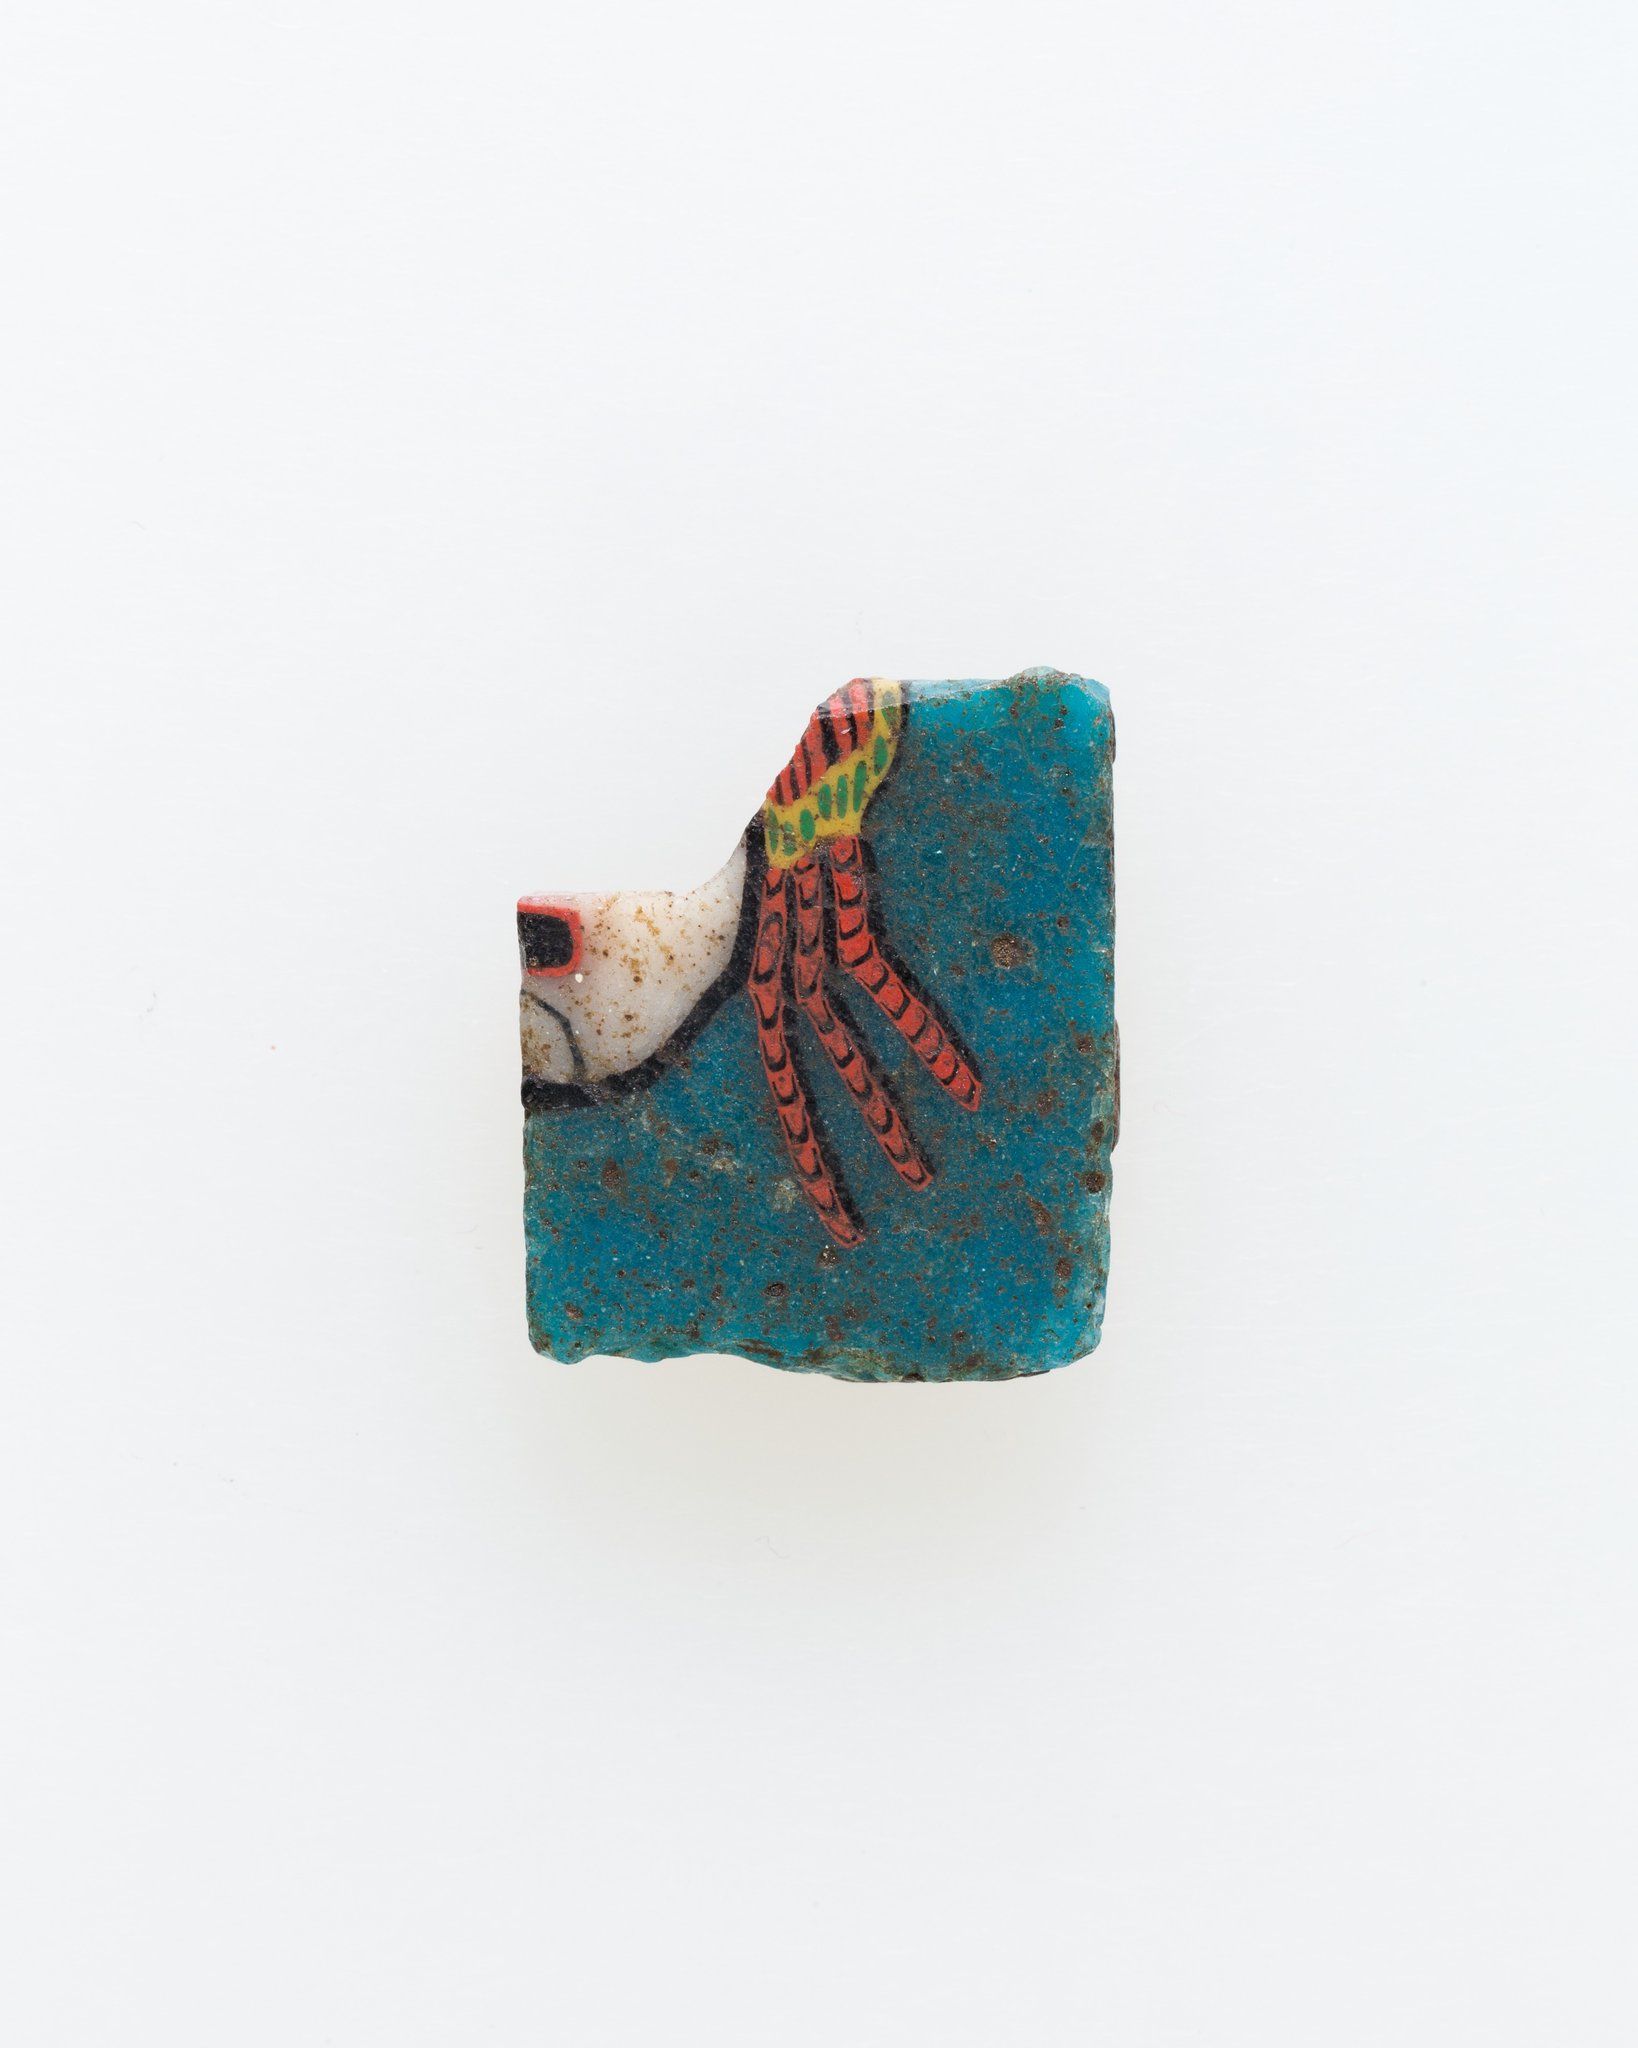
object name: inlay, fragment, maenad hair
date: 100 BCE-100 CE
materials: glass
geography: egypt